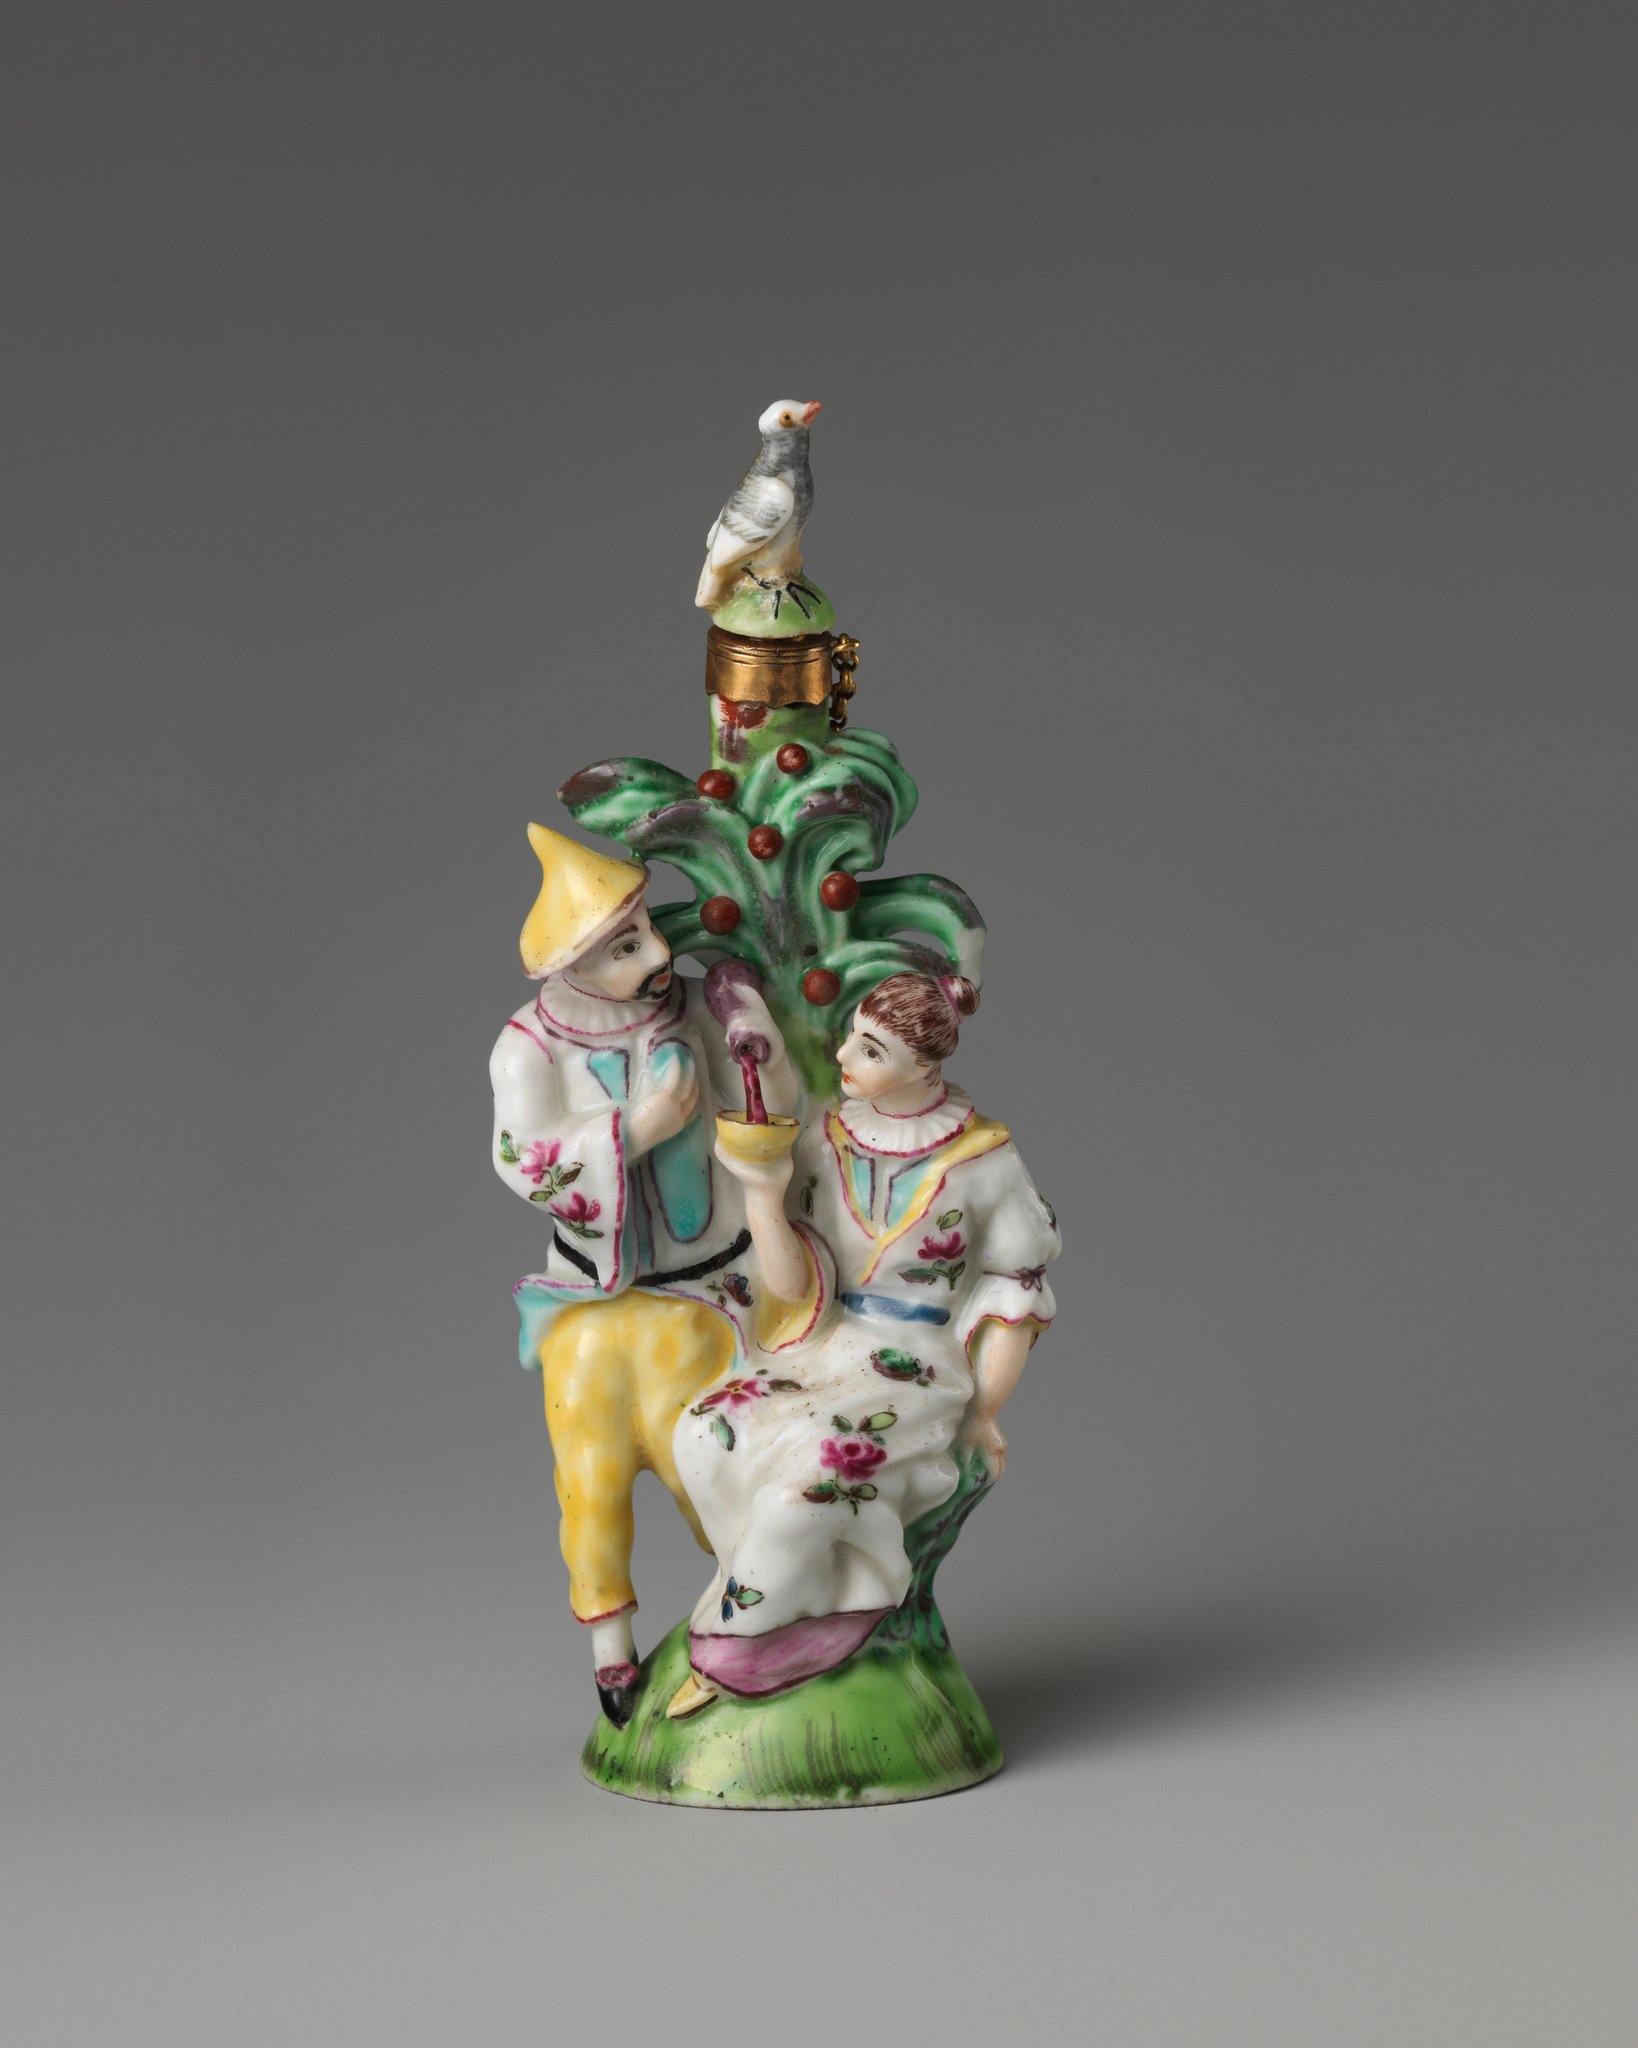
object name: toy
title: Chinese couple in a group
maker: saint james's factory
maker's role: maker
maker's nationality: british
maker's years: 1749-1759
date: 1755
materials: soft paste porcelain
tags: birds,chinoiserie,couples,men,women